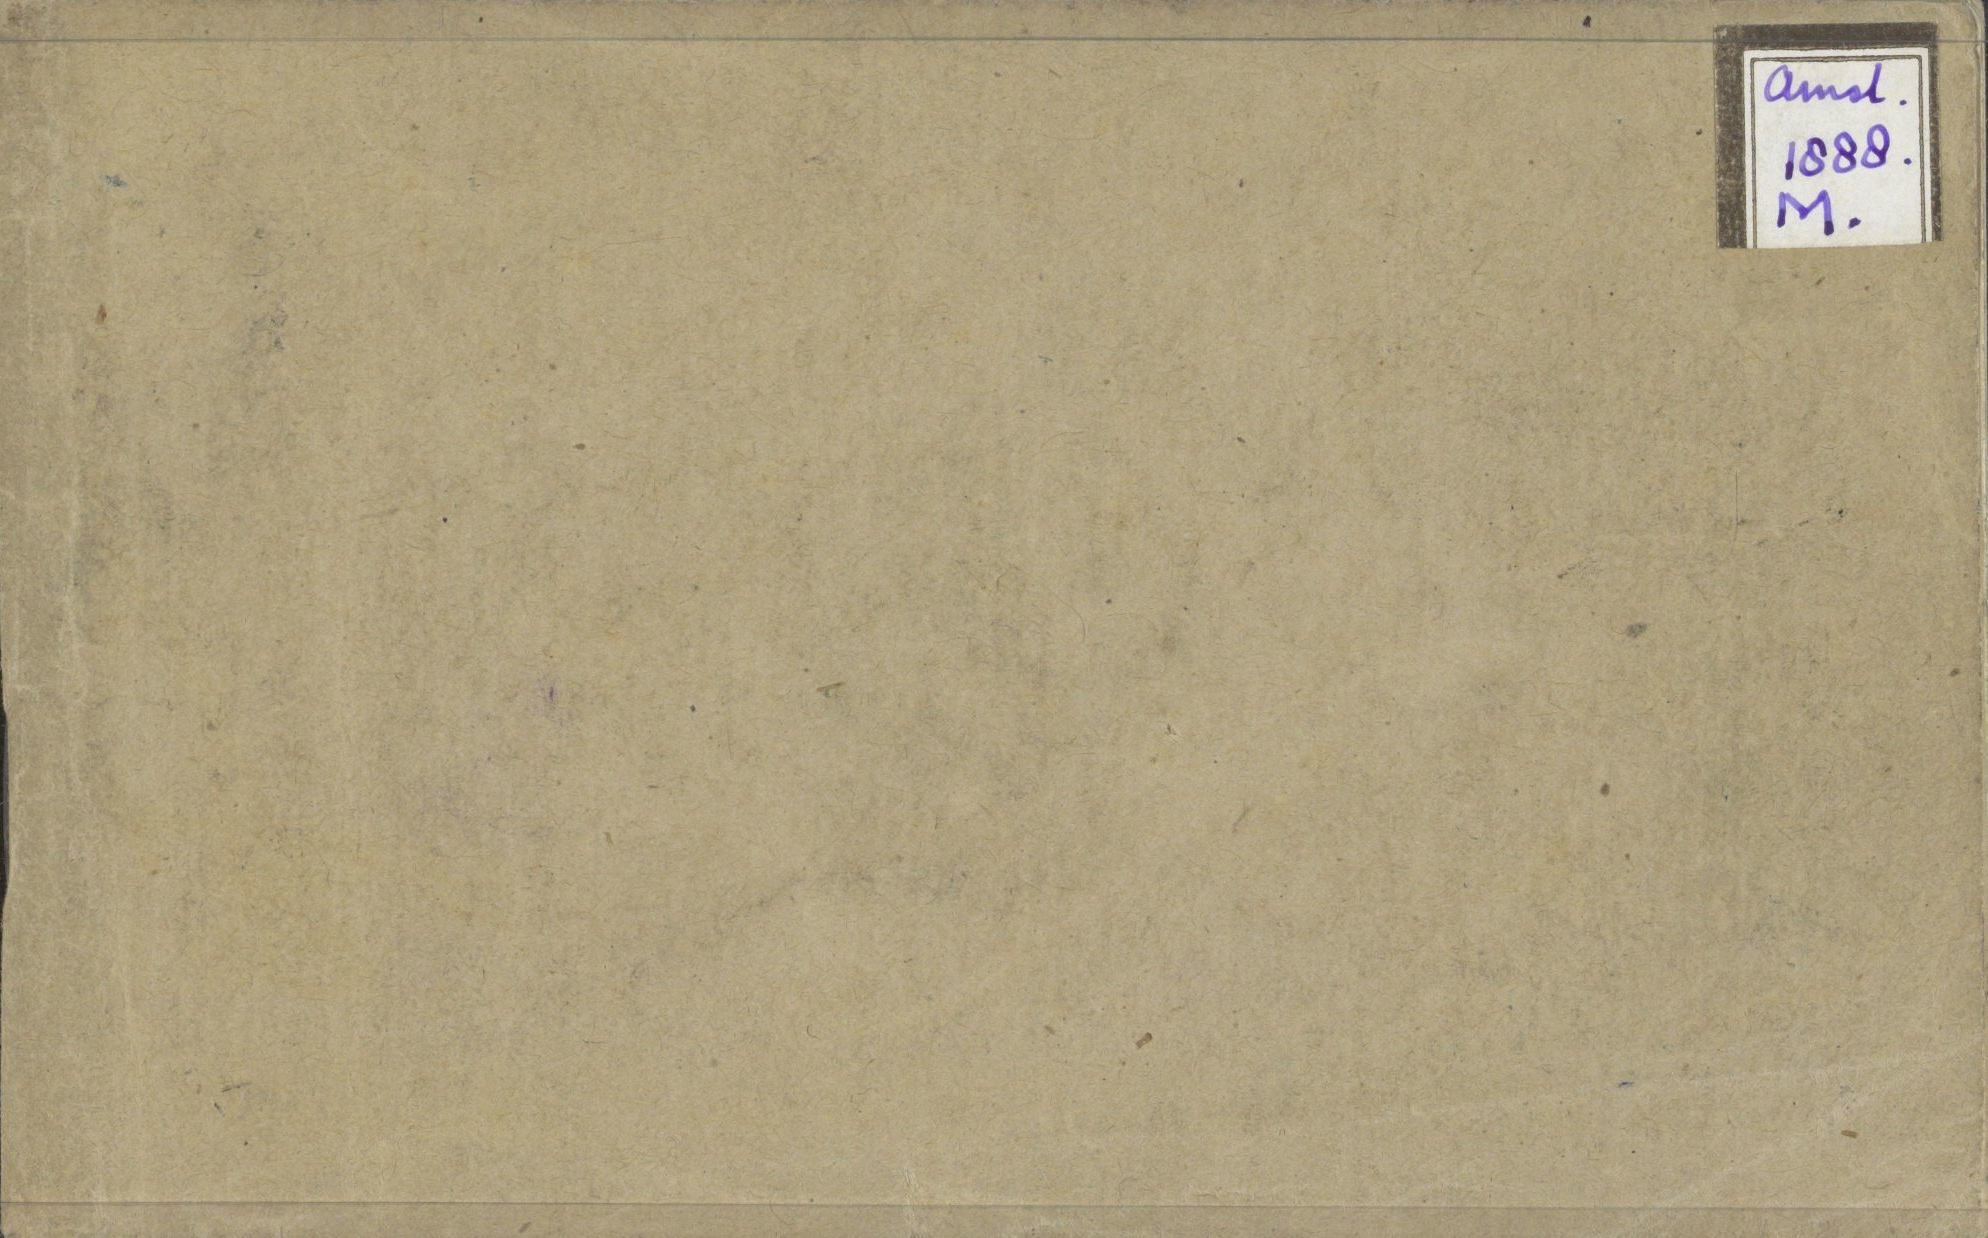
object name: sketchbook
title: Schetsboek met 24 bladen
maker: george hendrik breitner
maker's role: draughtsman, painter, print maker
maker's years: 1857-1923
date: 1888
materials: chalk, paper, pencil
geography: amsterdam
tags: church (exterior), canals, waters (in city), amsterdam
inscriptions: workshop stamp: Lugt 291d, annotation: ‘Amst./ 1888./ M.’, collector's mark: Lugt 2228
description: Schetsboek bestaande uit 24 bladen, waarvan zes met gezichten in Amsterdam.